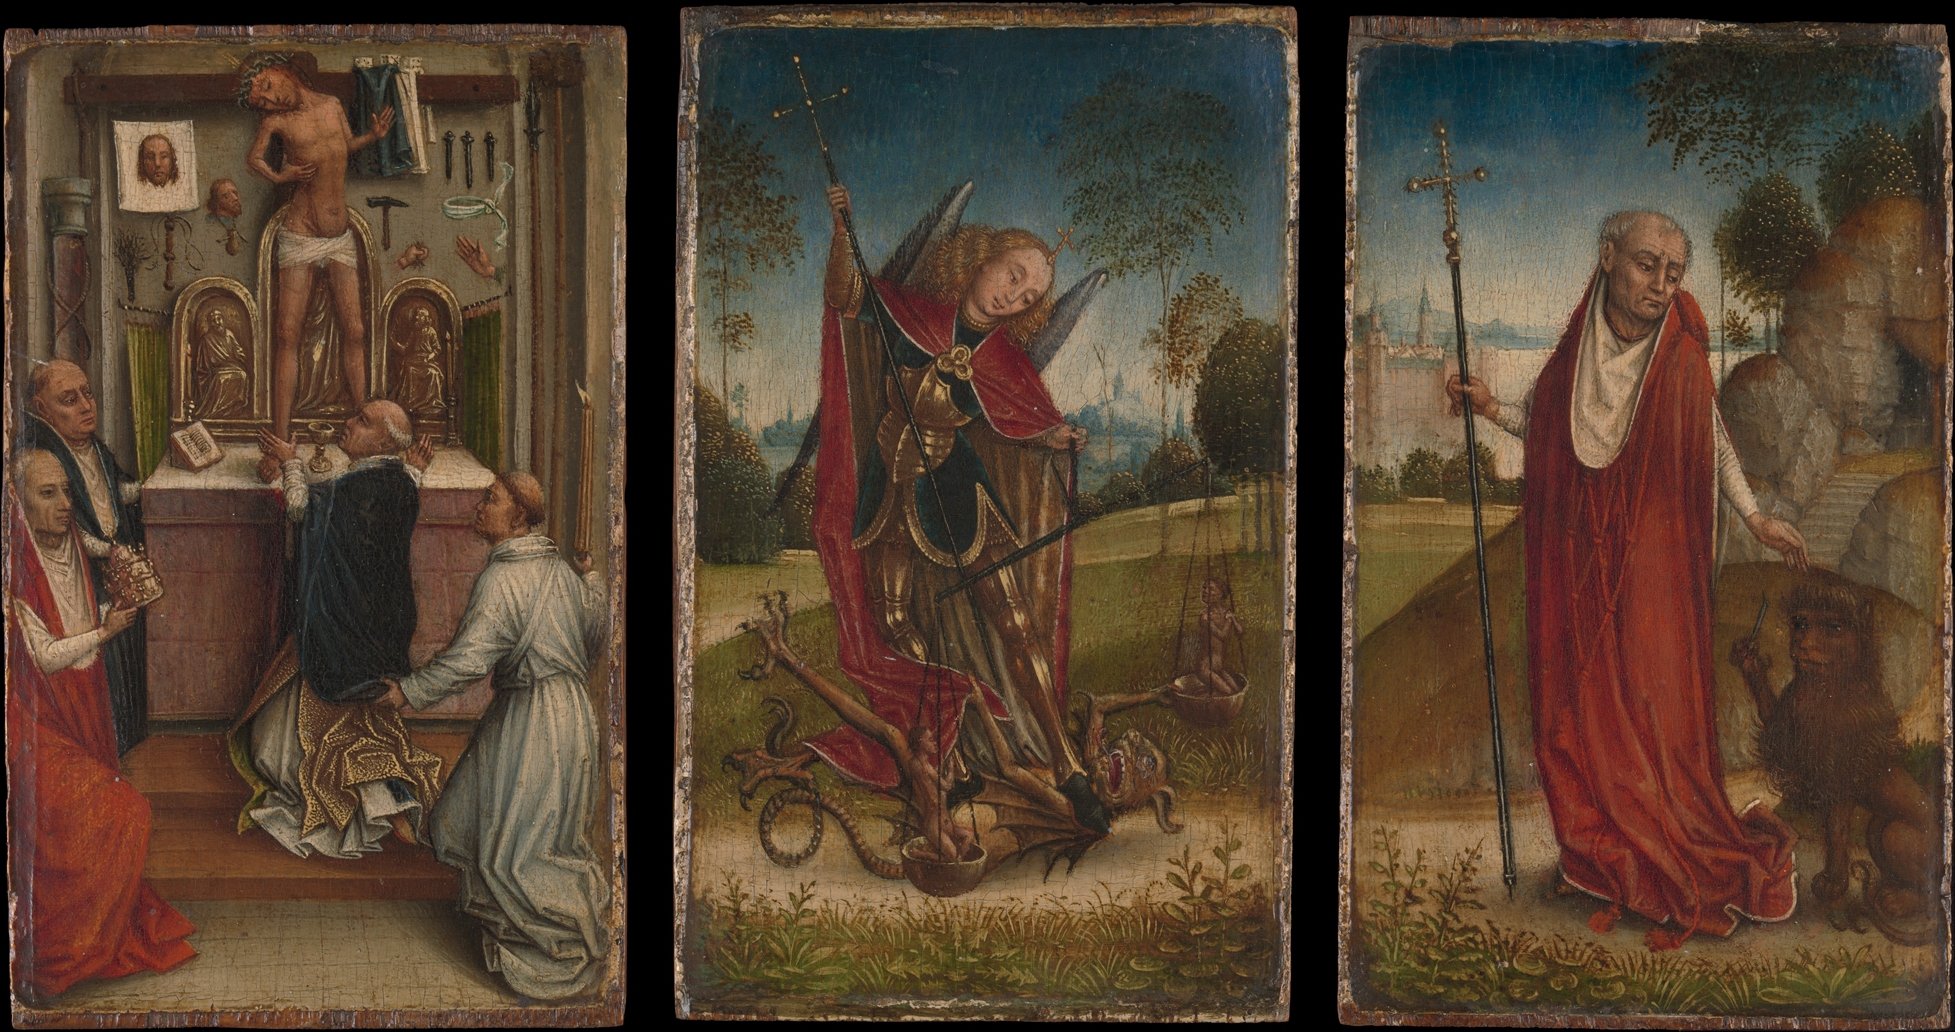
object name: painting, part of a polyptych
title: Saint Michael; The Mass of Saint Gregory; Saint Jerome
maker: master of the saint catherine legend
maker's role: artist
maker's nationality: netherlandish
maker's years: 1470-1500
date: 1450-1499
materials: oil, wood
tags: men,women,lions,christ,saint jerome,saint michael,demons